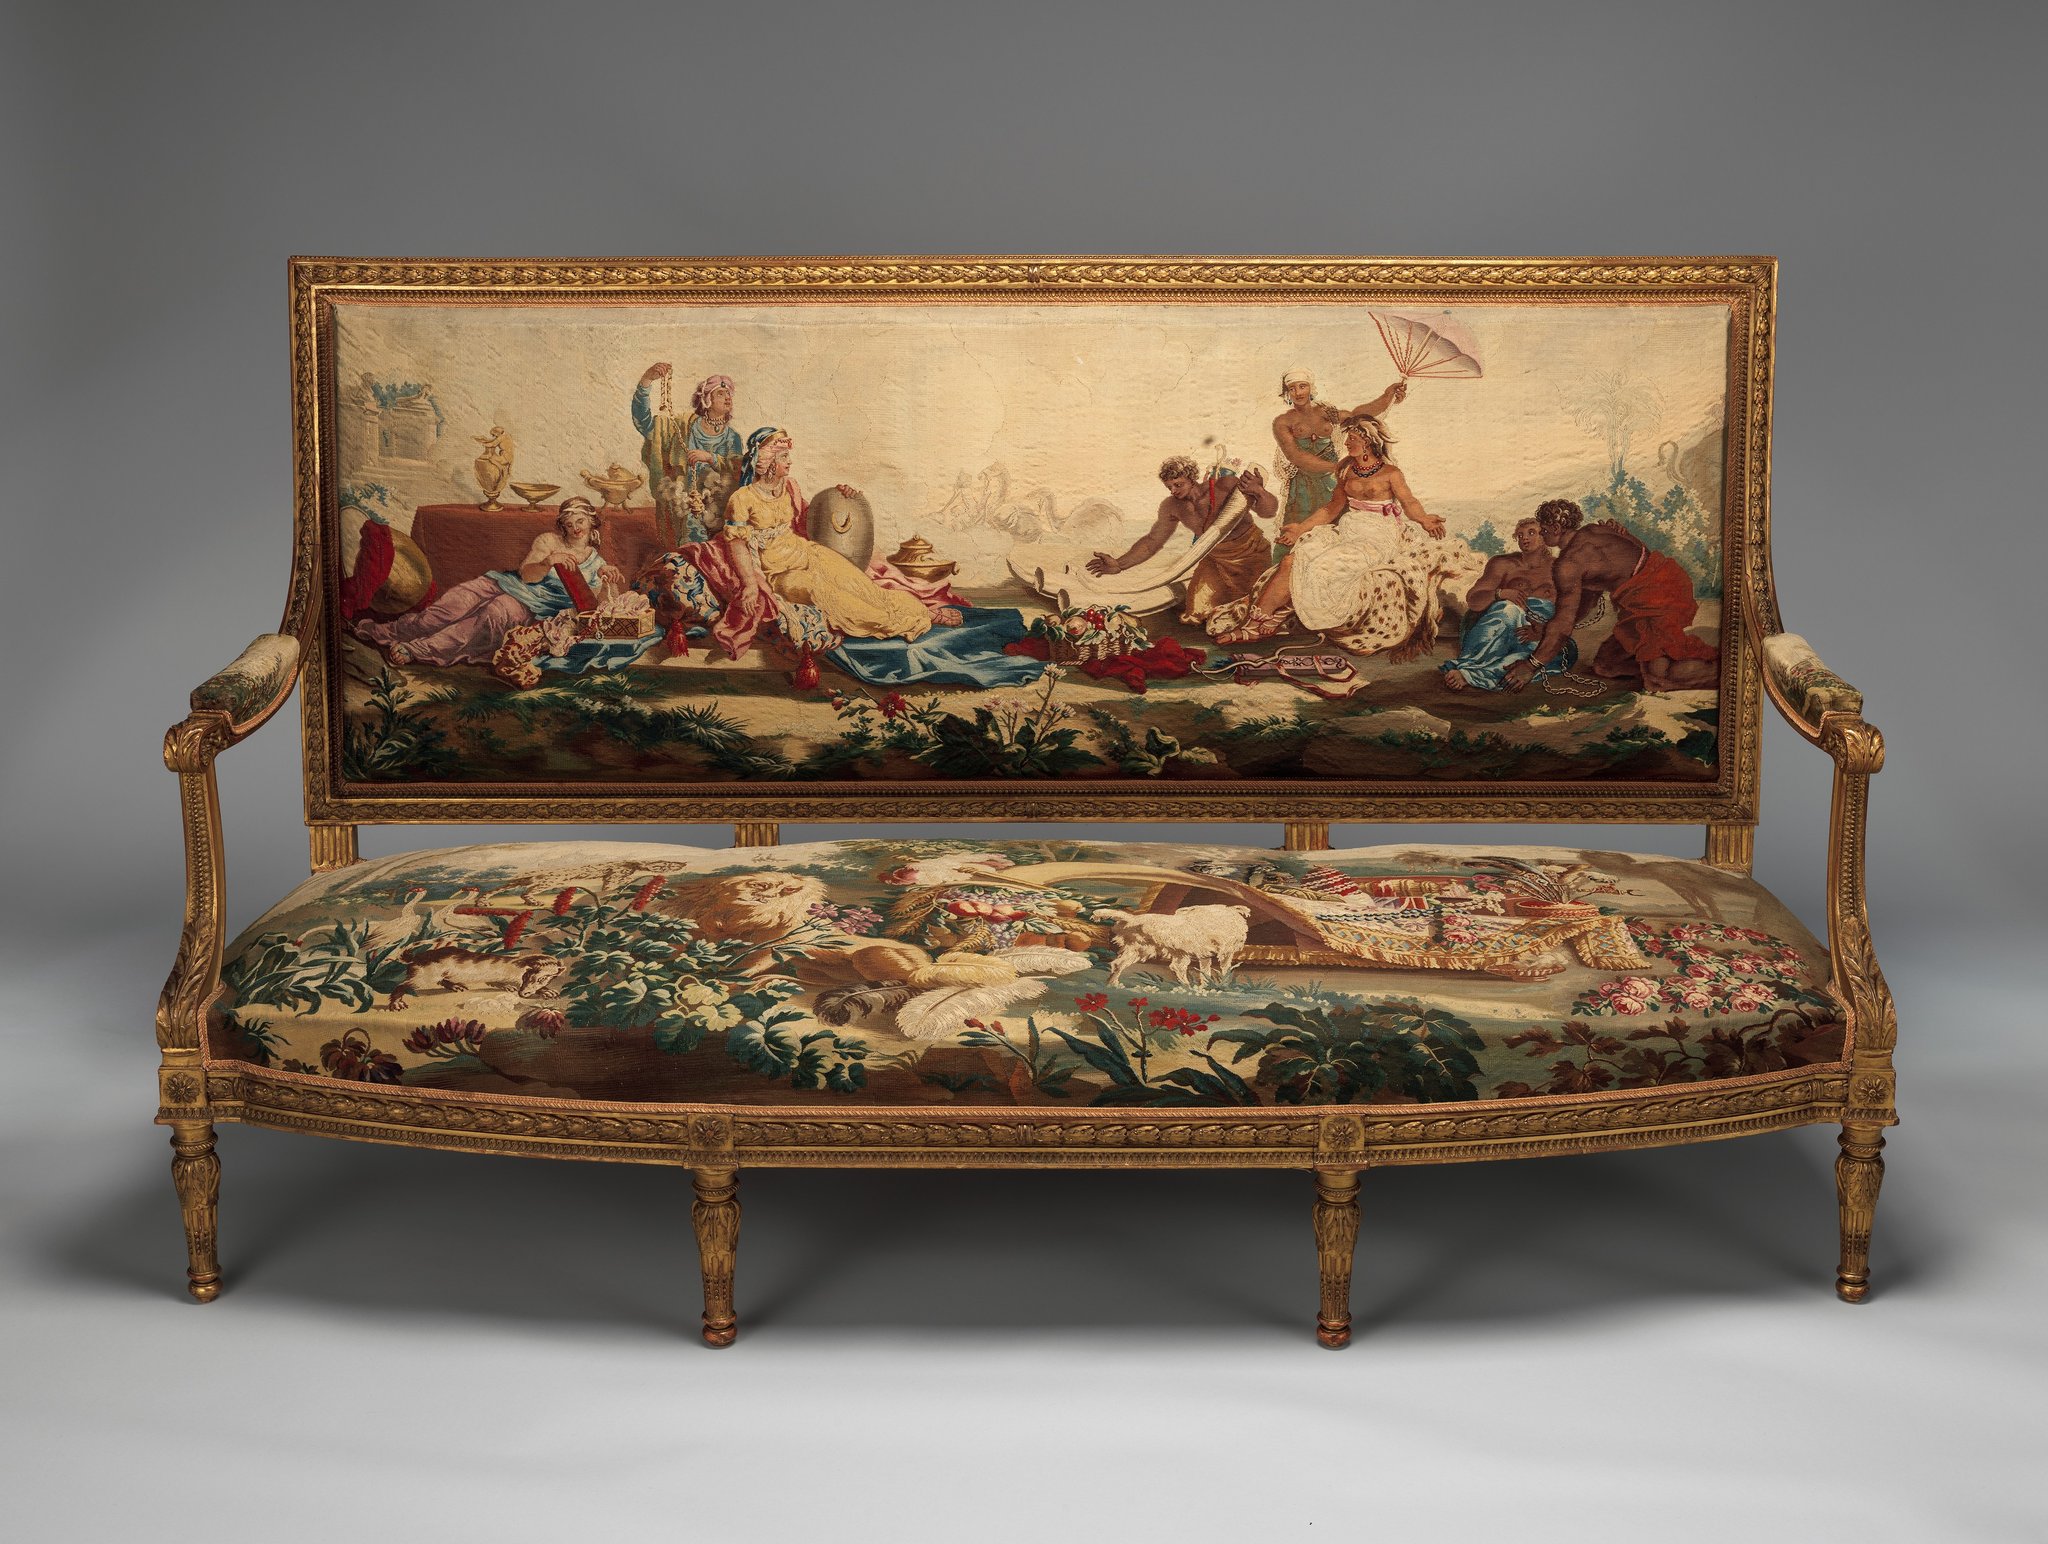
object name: settee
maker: beauvais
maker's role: manufactory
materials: silk, wood, wool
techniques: carving, gilding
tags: birds,men,women,camels,leopards,lions